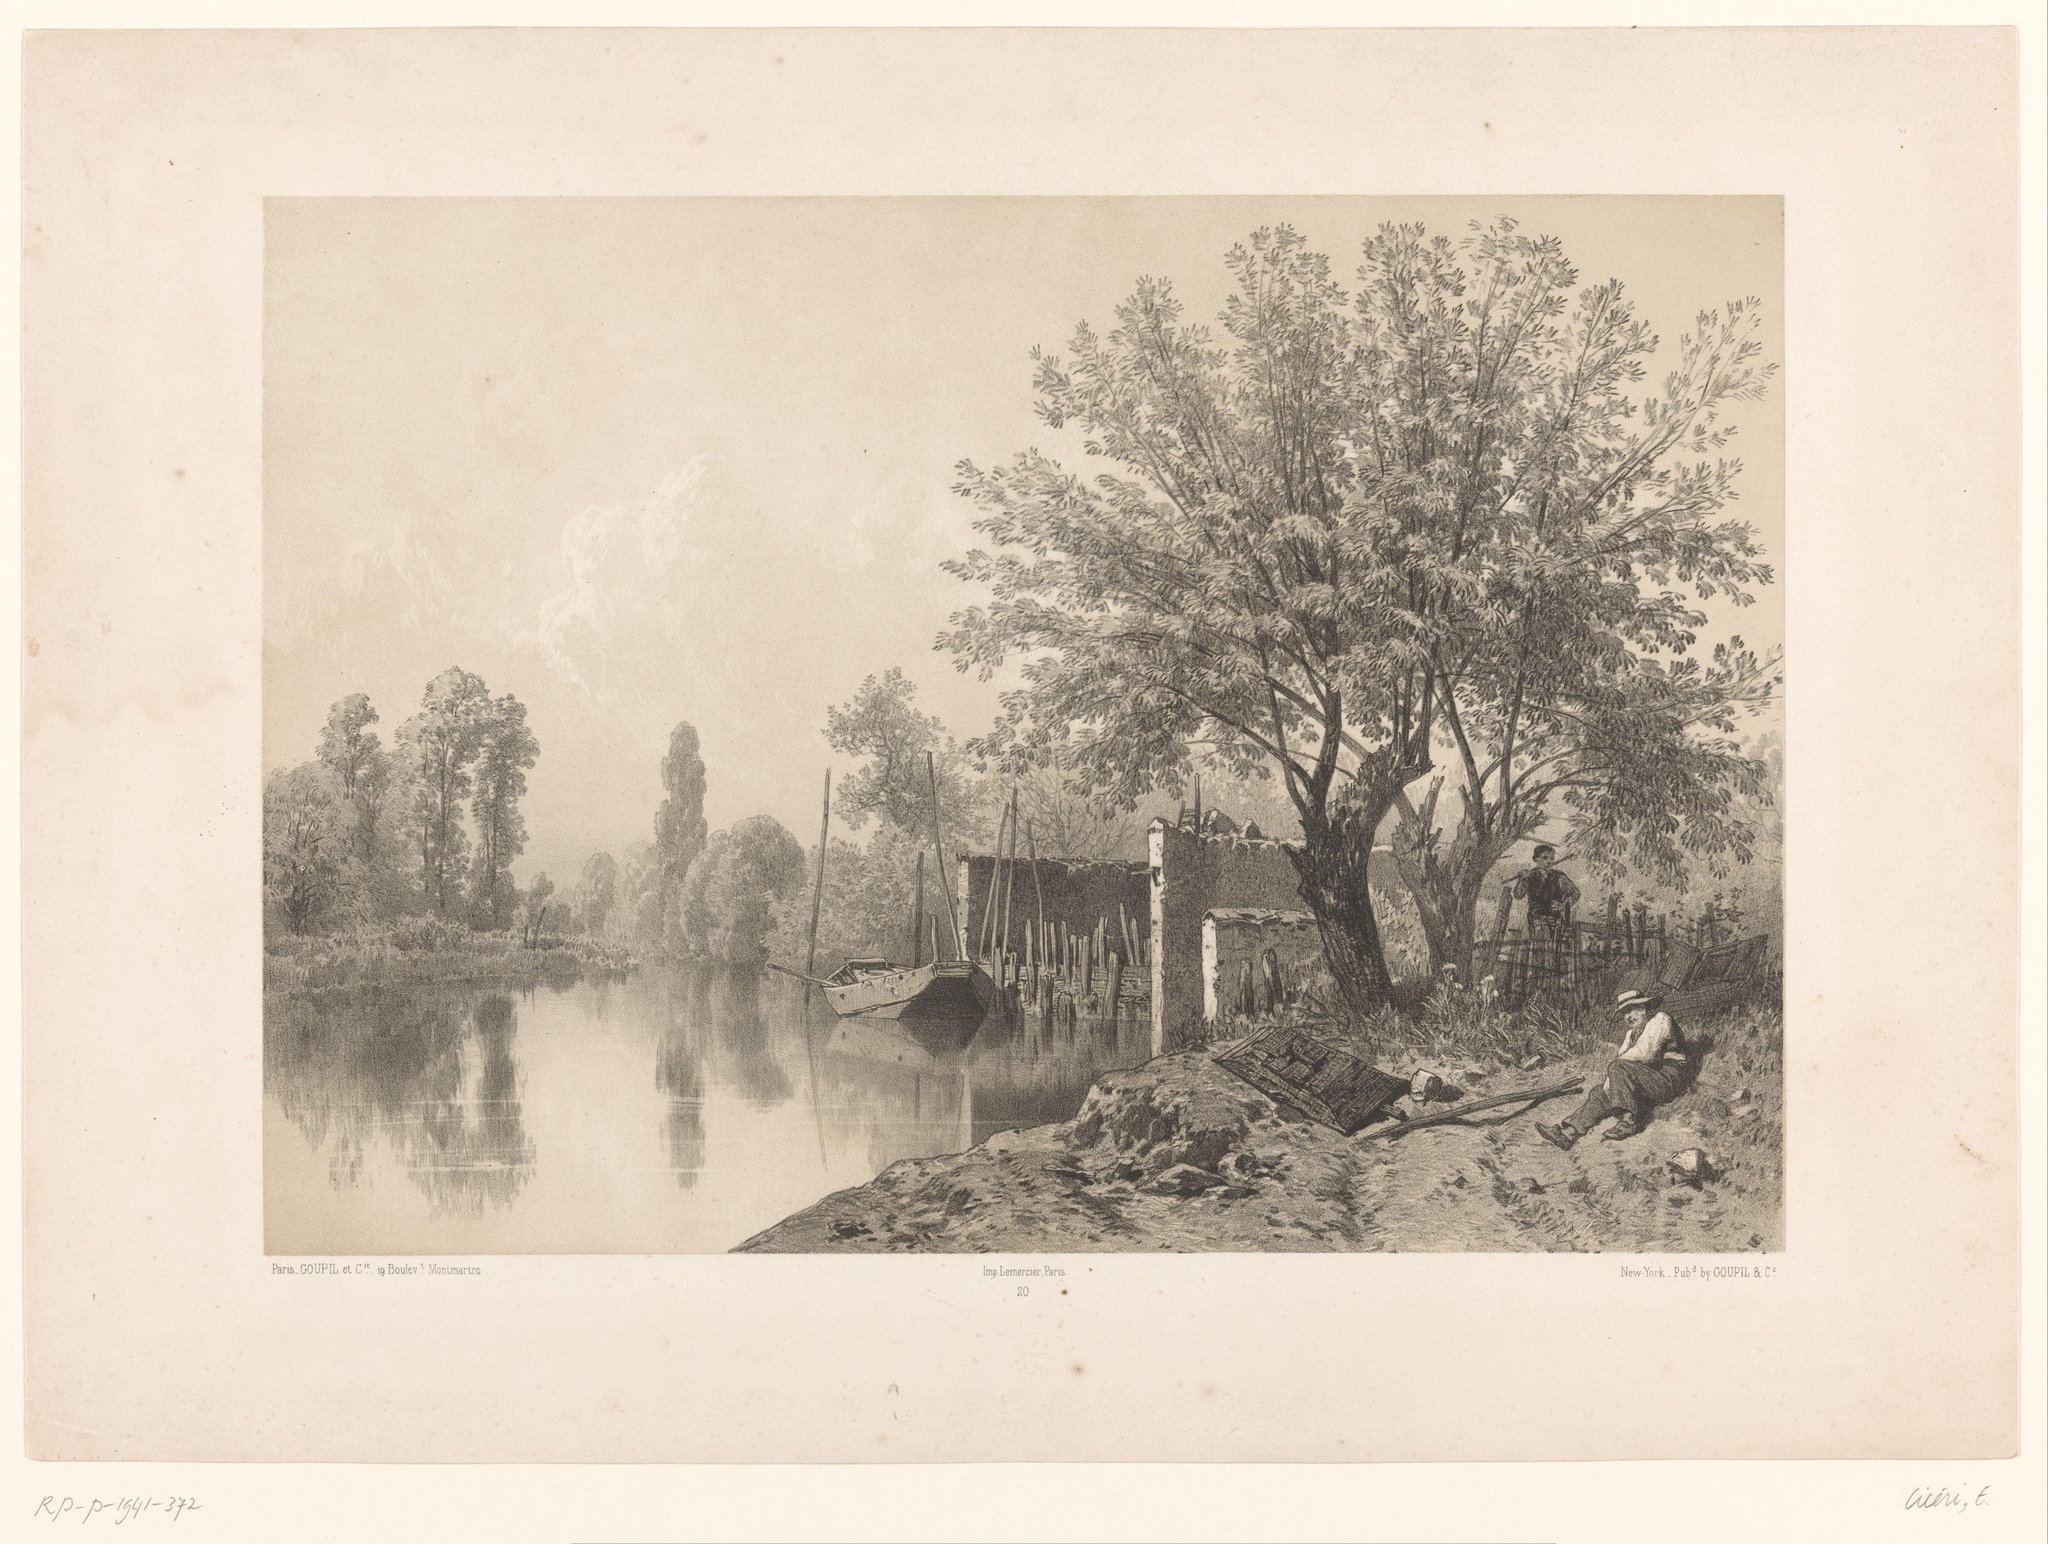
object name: print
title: Rivieroever met rustende visser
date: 1835-1879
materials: paper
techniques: tone lithography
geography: paris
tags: commercial fishery, river, resting - bb - out of doors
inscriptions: collector's mark: Lugt 2760, collector's mark: Lugt 2228a, check stamp: Lugt 1090